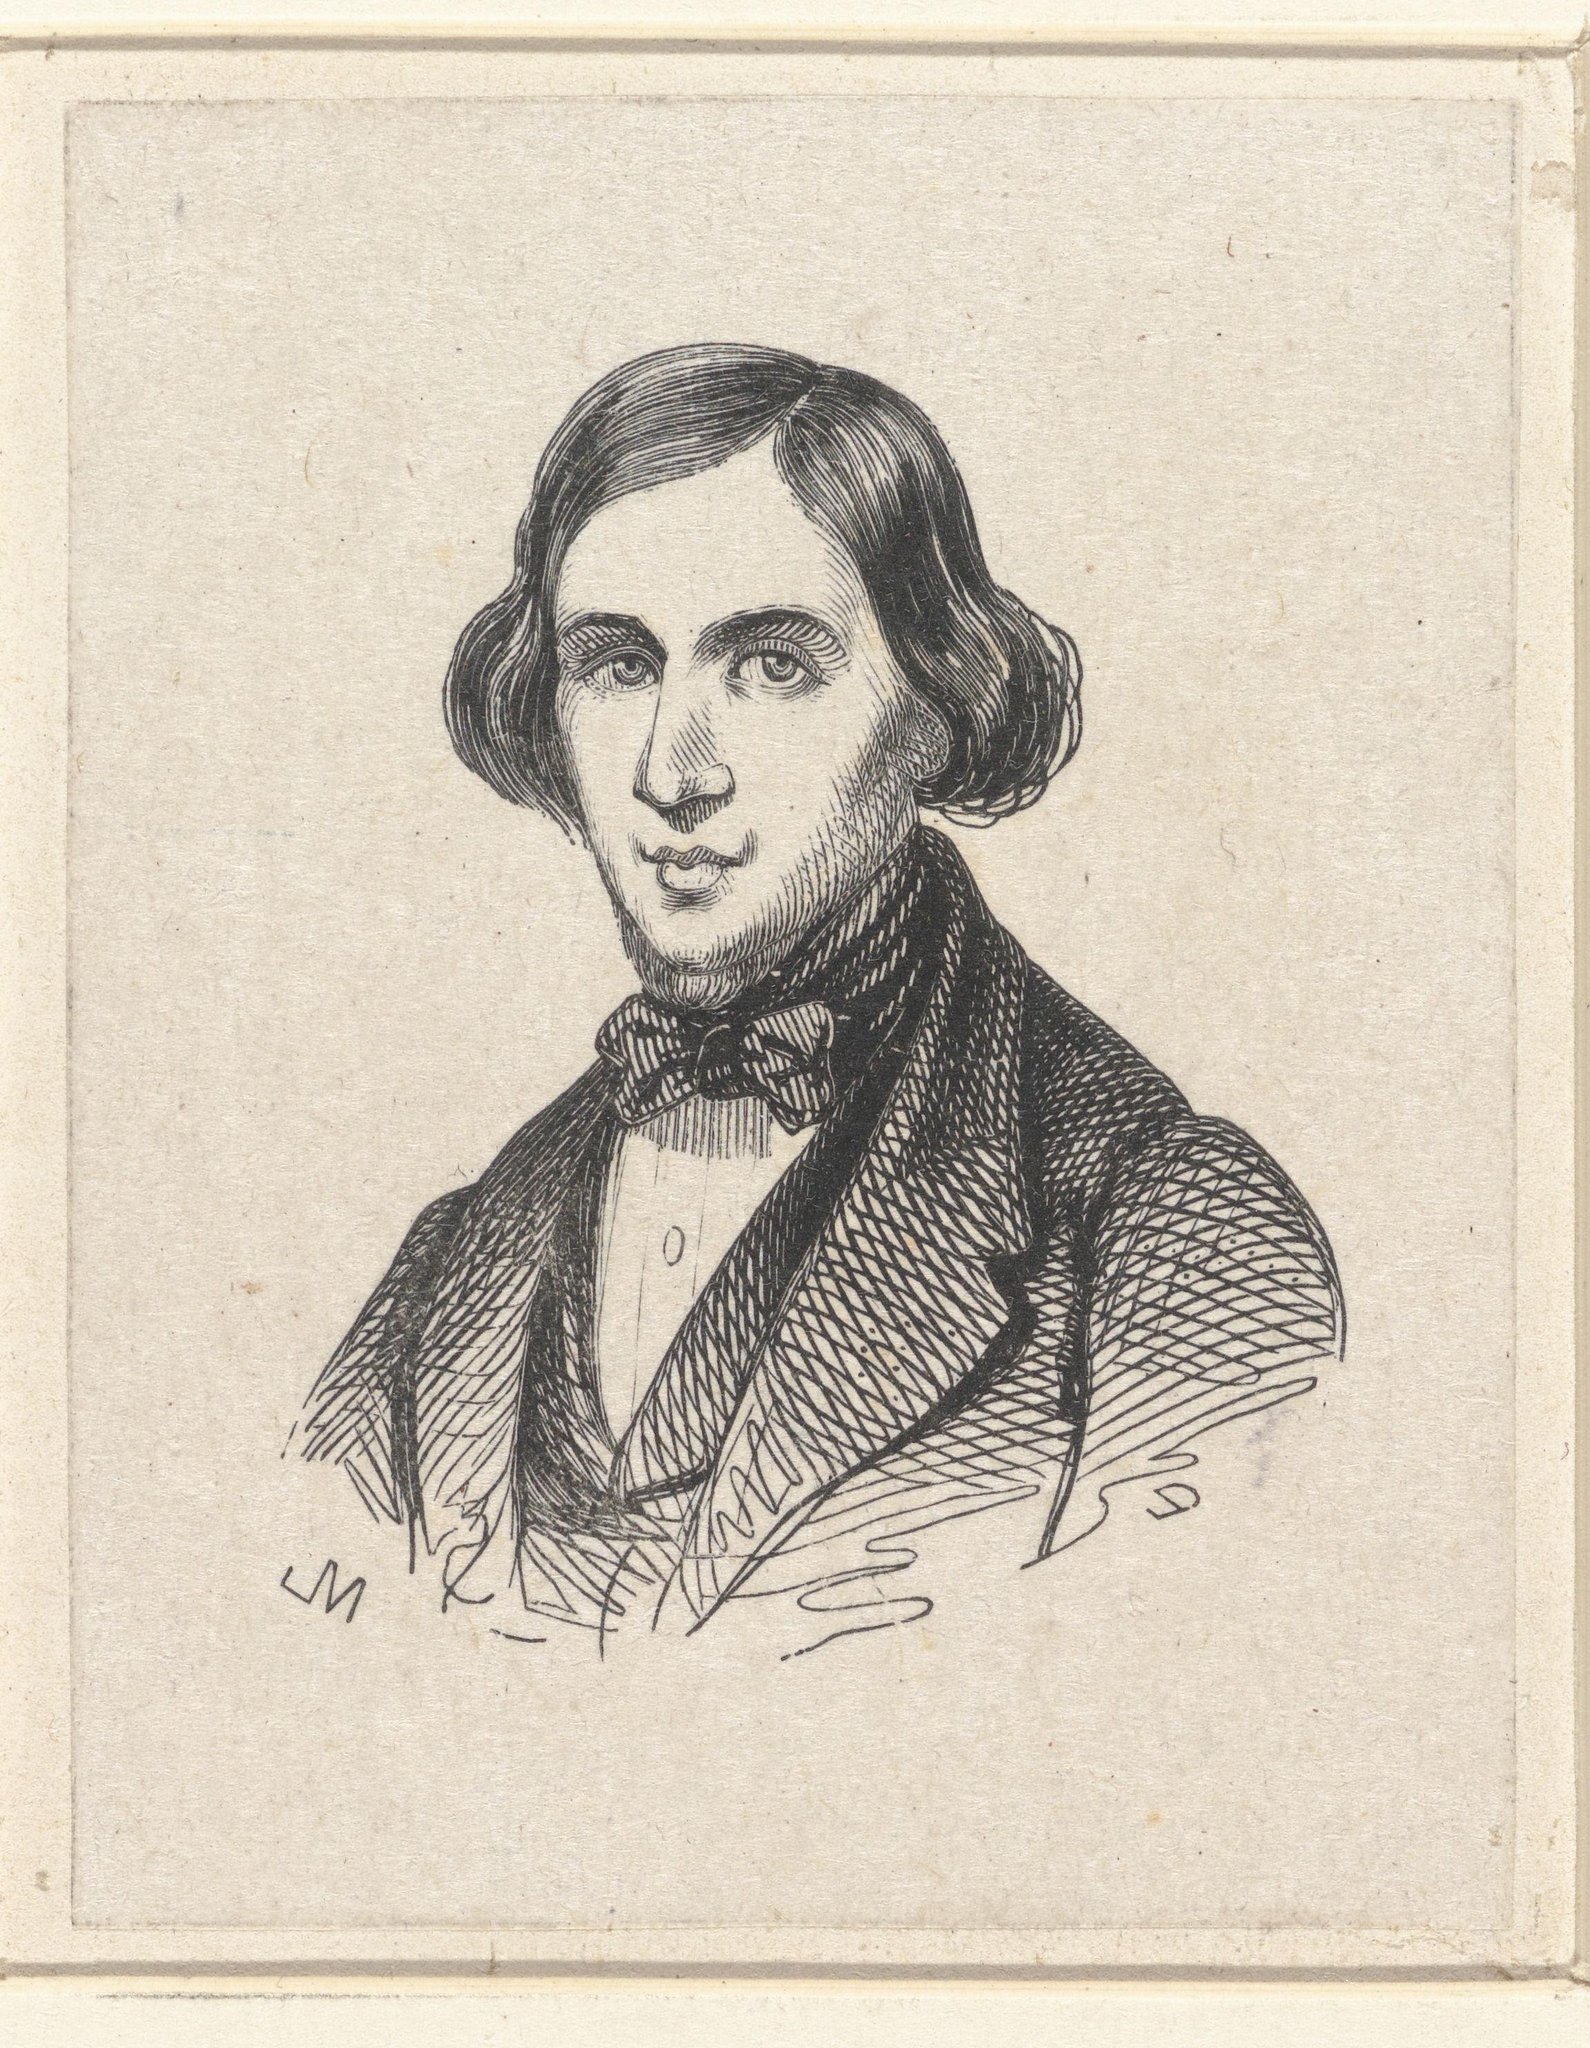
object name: print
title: Portret van Pierre Louis Dubourq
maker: monogrammist m (duitsland)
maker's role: print maker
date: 1841-1842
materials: paper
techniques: engraving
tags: amsterdam, painter, print maker, draughtsman, pierre louis dubourcq, historical persons, portrait, self-portrait of painter, portrait, self-portrait of artist, portrait, self-portrait of draughtsman